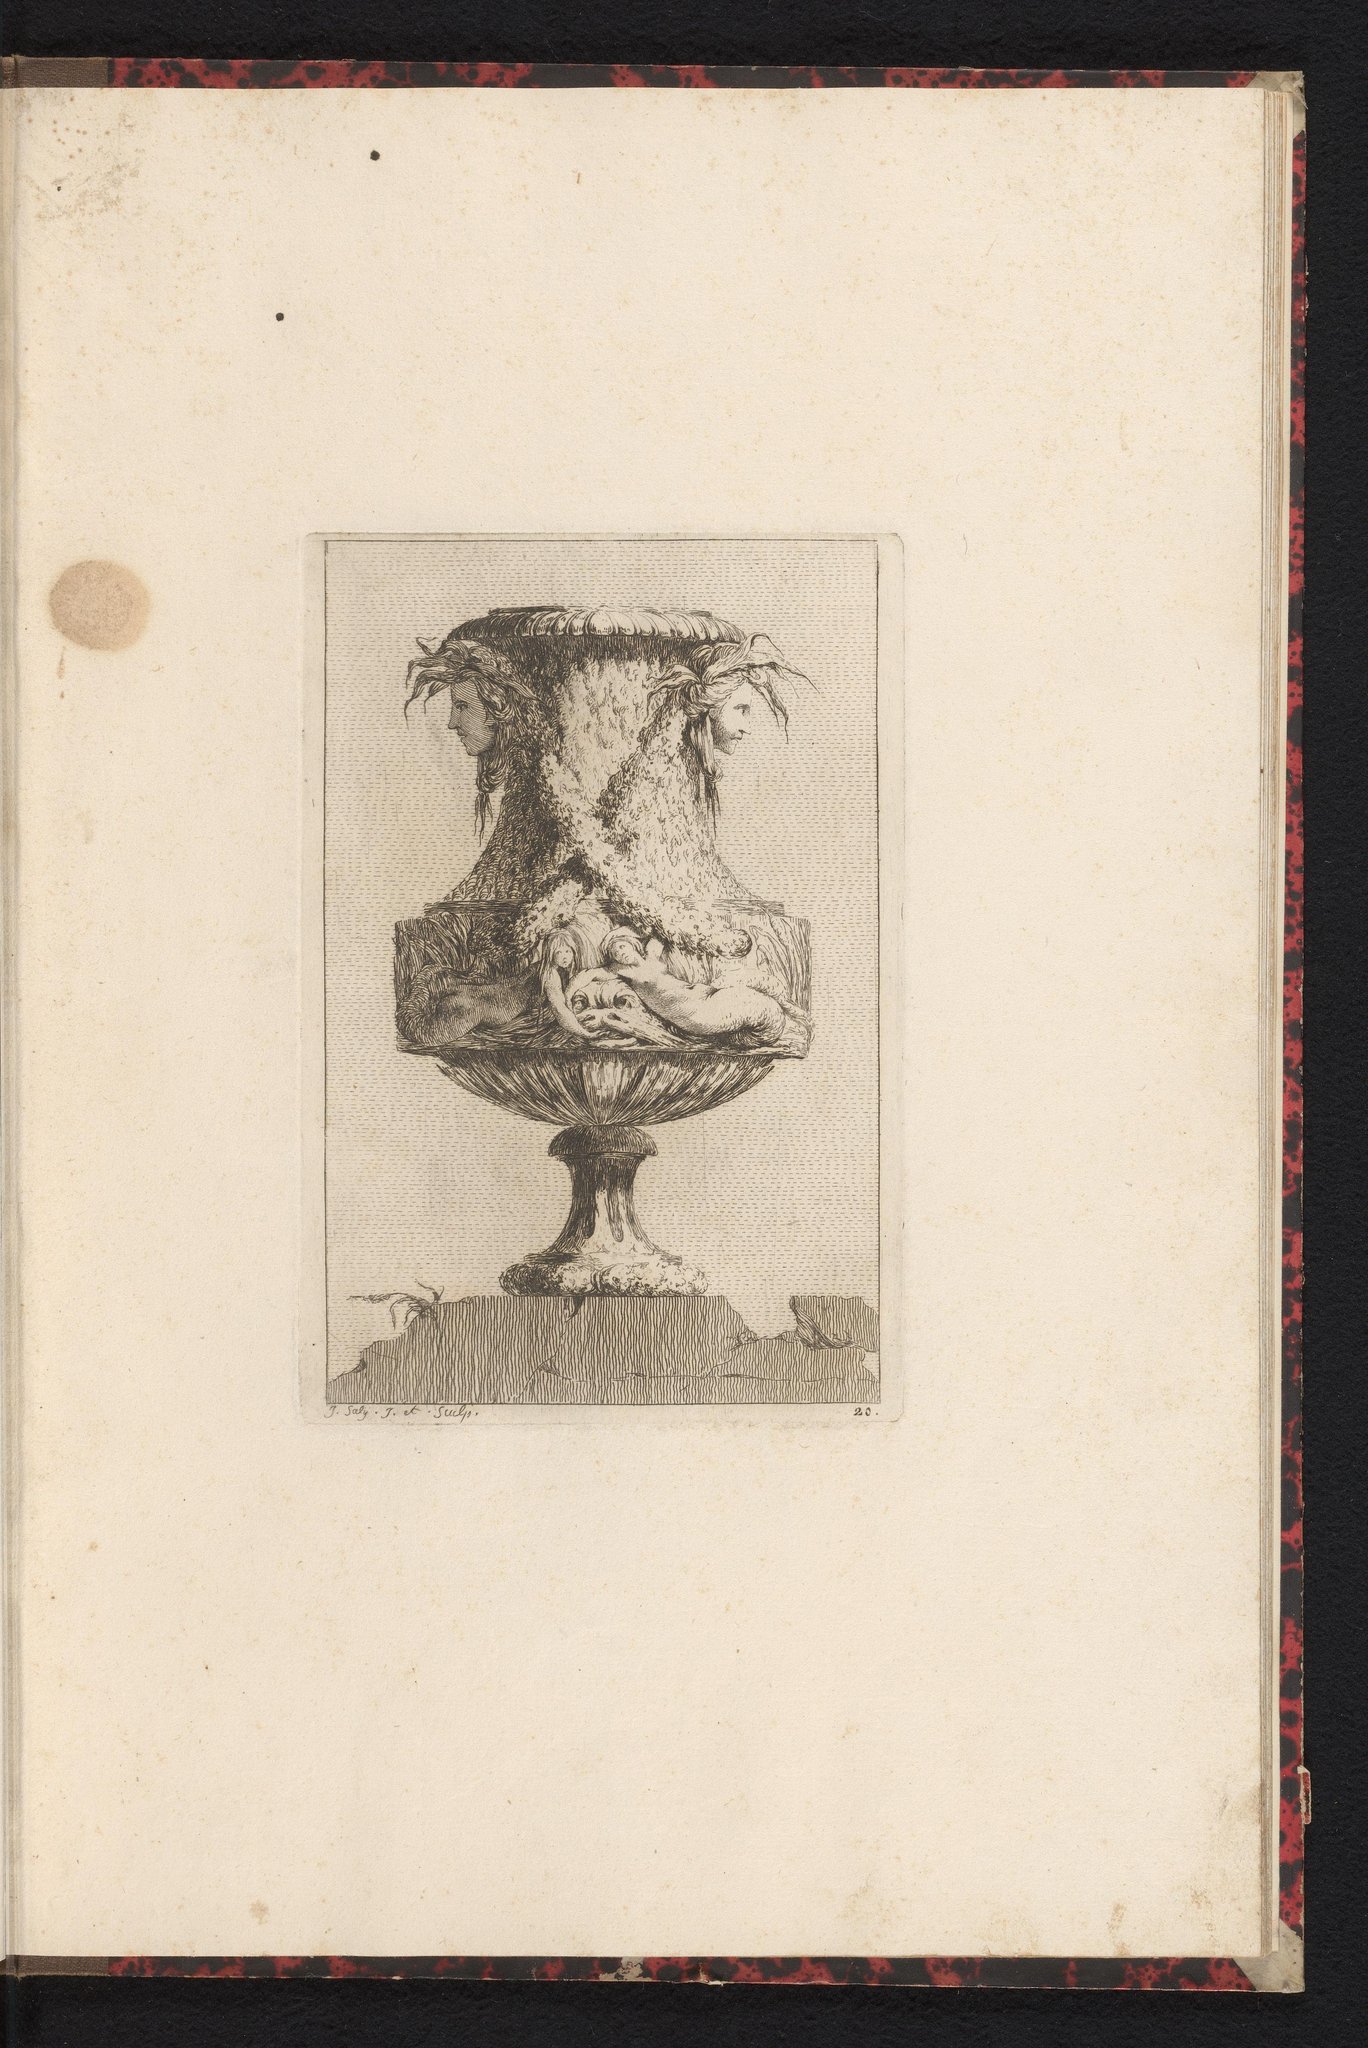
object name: print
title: Vaas met meerminnen, dolfijn en guirlandes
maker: jacques francois joseph saly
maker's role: print maker, sculptor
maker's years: 1717-1776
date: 1746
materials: paper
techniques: etching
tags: dolphin ~ ornament, merman - aa - mermaid, siren, ornament ~ festoon, garland, garden vase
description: Deze prent maakt deel uit van een album.